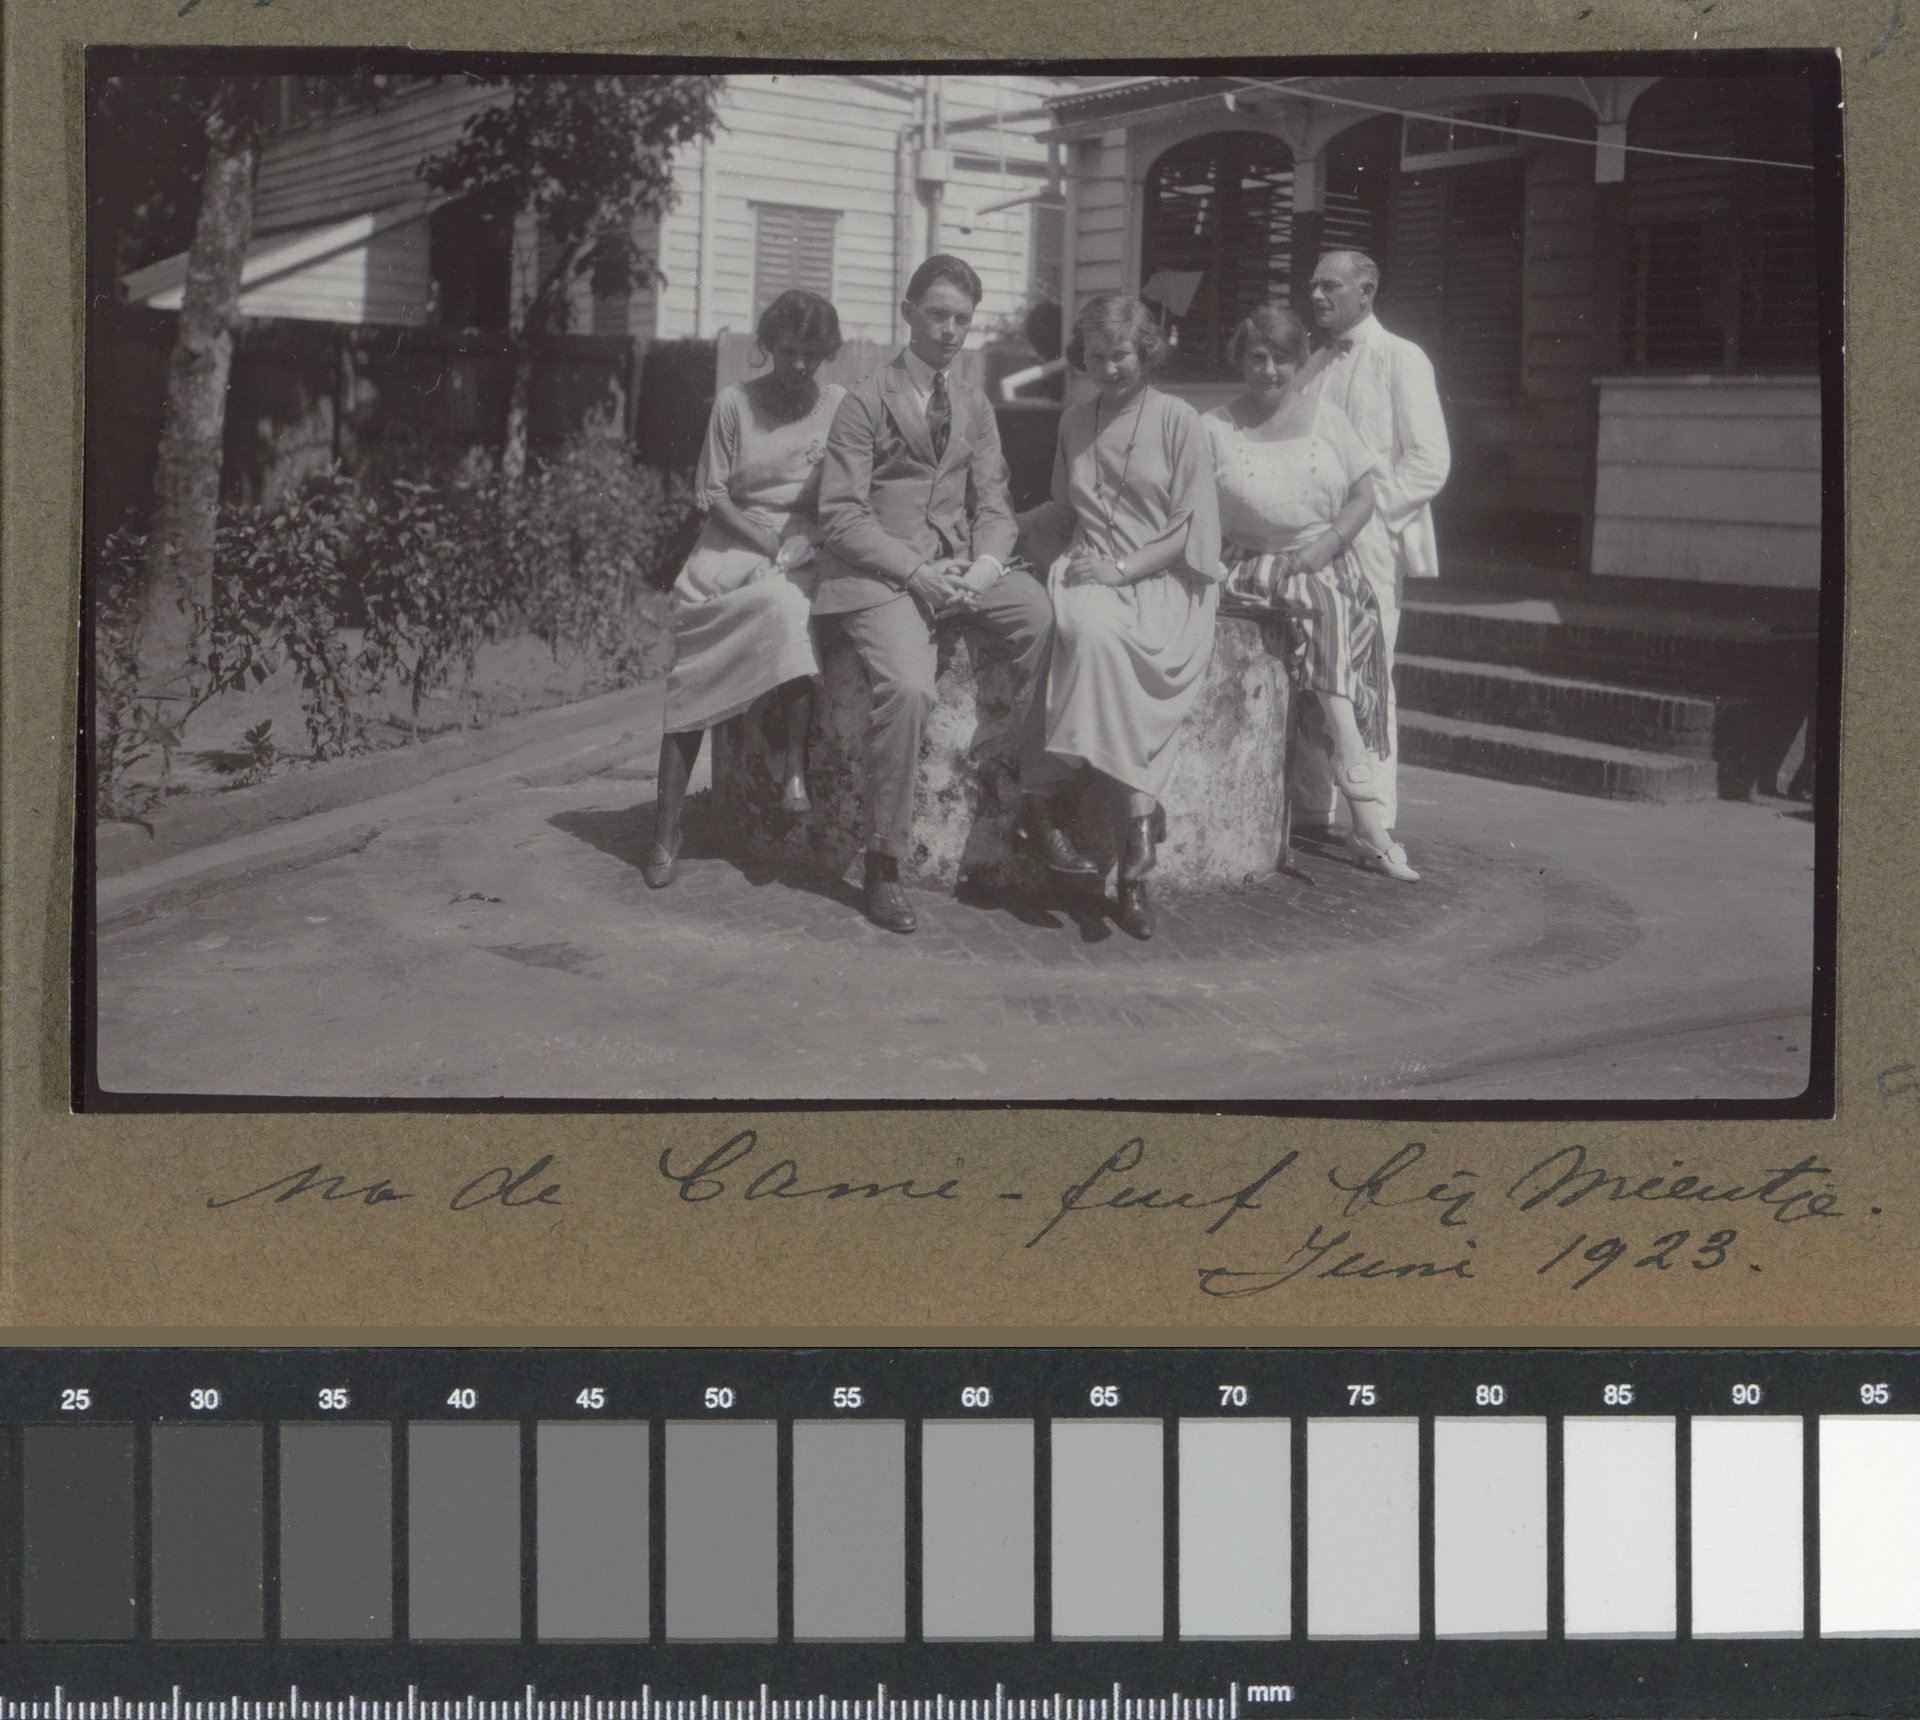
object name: photograph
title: Na de bami-fuif bij Mientje. Juni 1923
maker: Anonymous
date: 1906-1923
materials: photographic support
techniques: gelatin silver print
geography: suriname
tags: adult woman, adult man, suriname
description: Onderdeel van fotoalbum van een onbekende Nederlandse familie met opnames van Suriname, Europa en Nederlands-Indië.